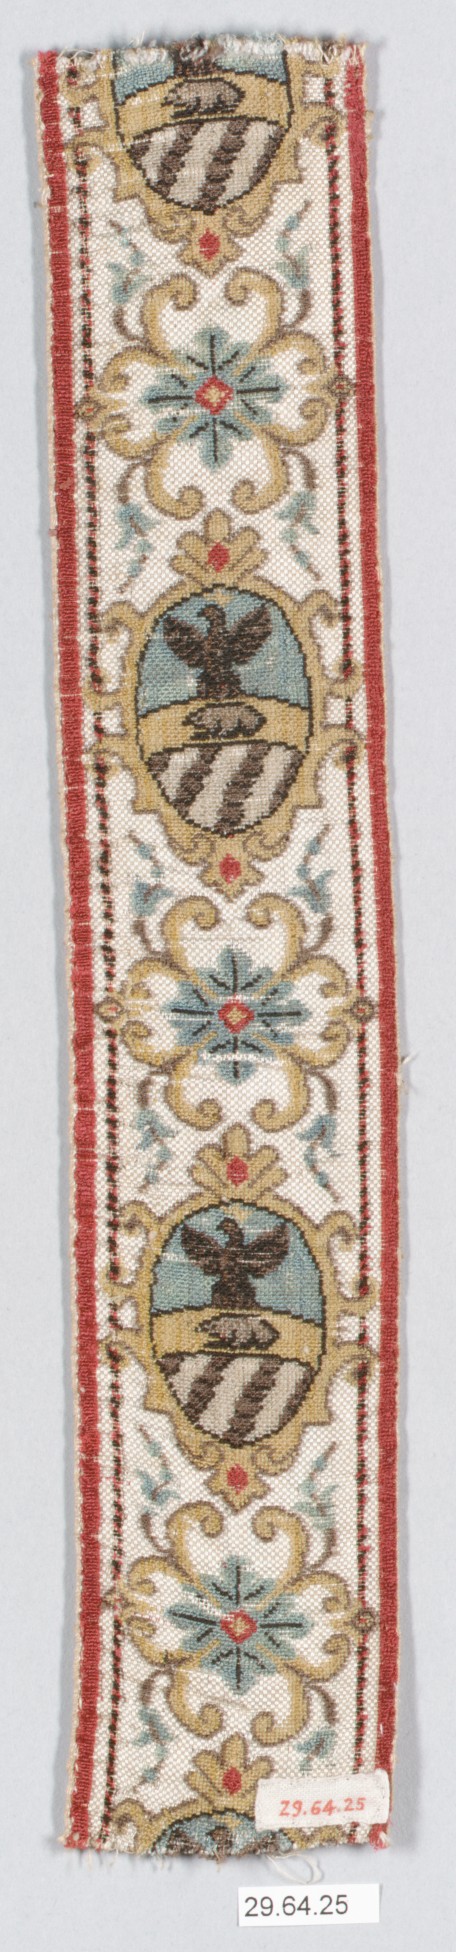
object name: galloon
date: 1701-1900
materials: silk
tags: birds